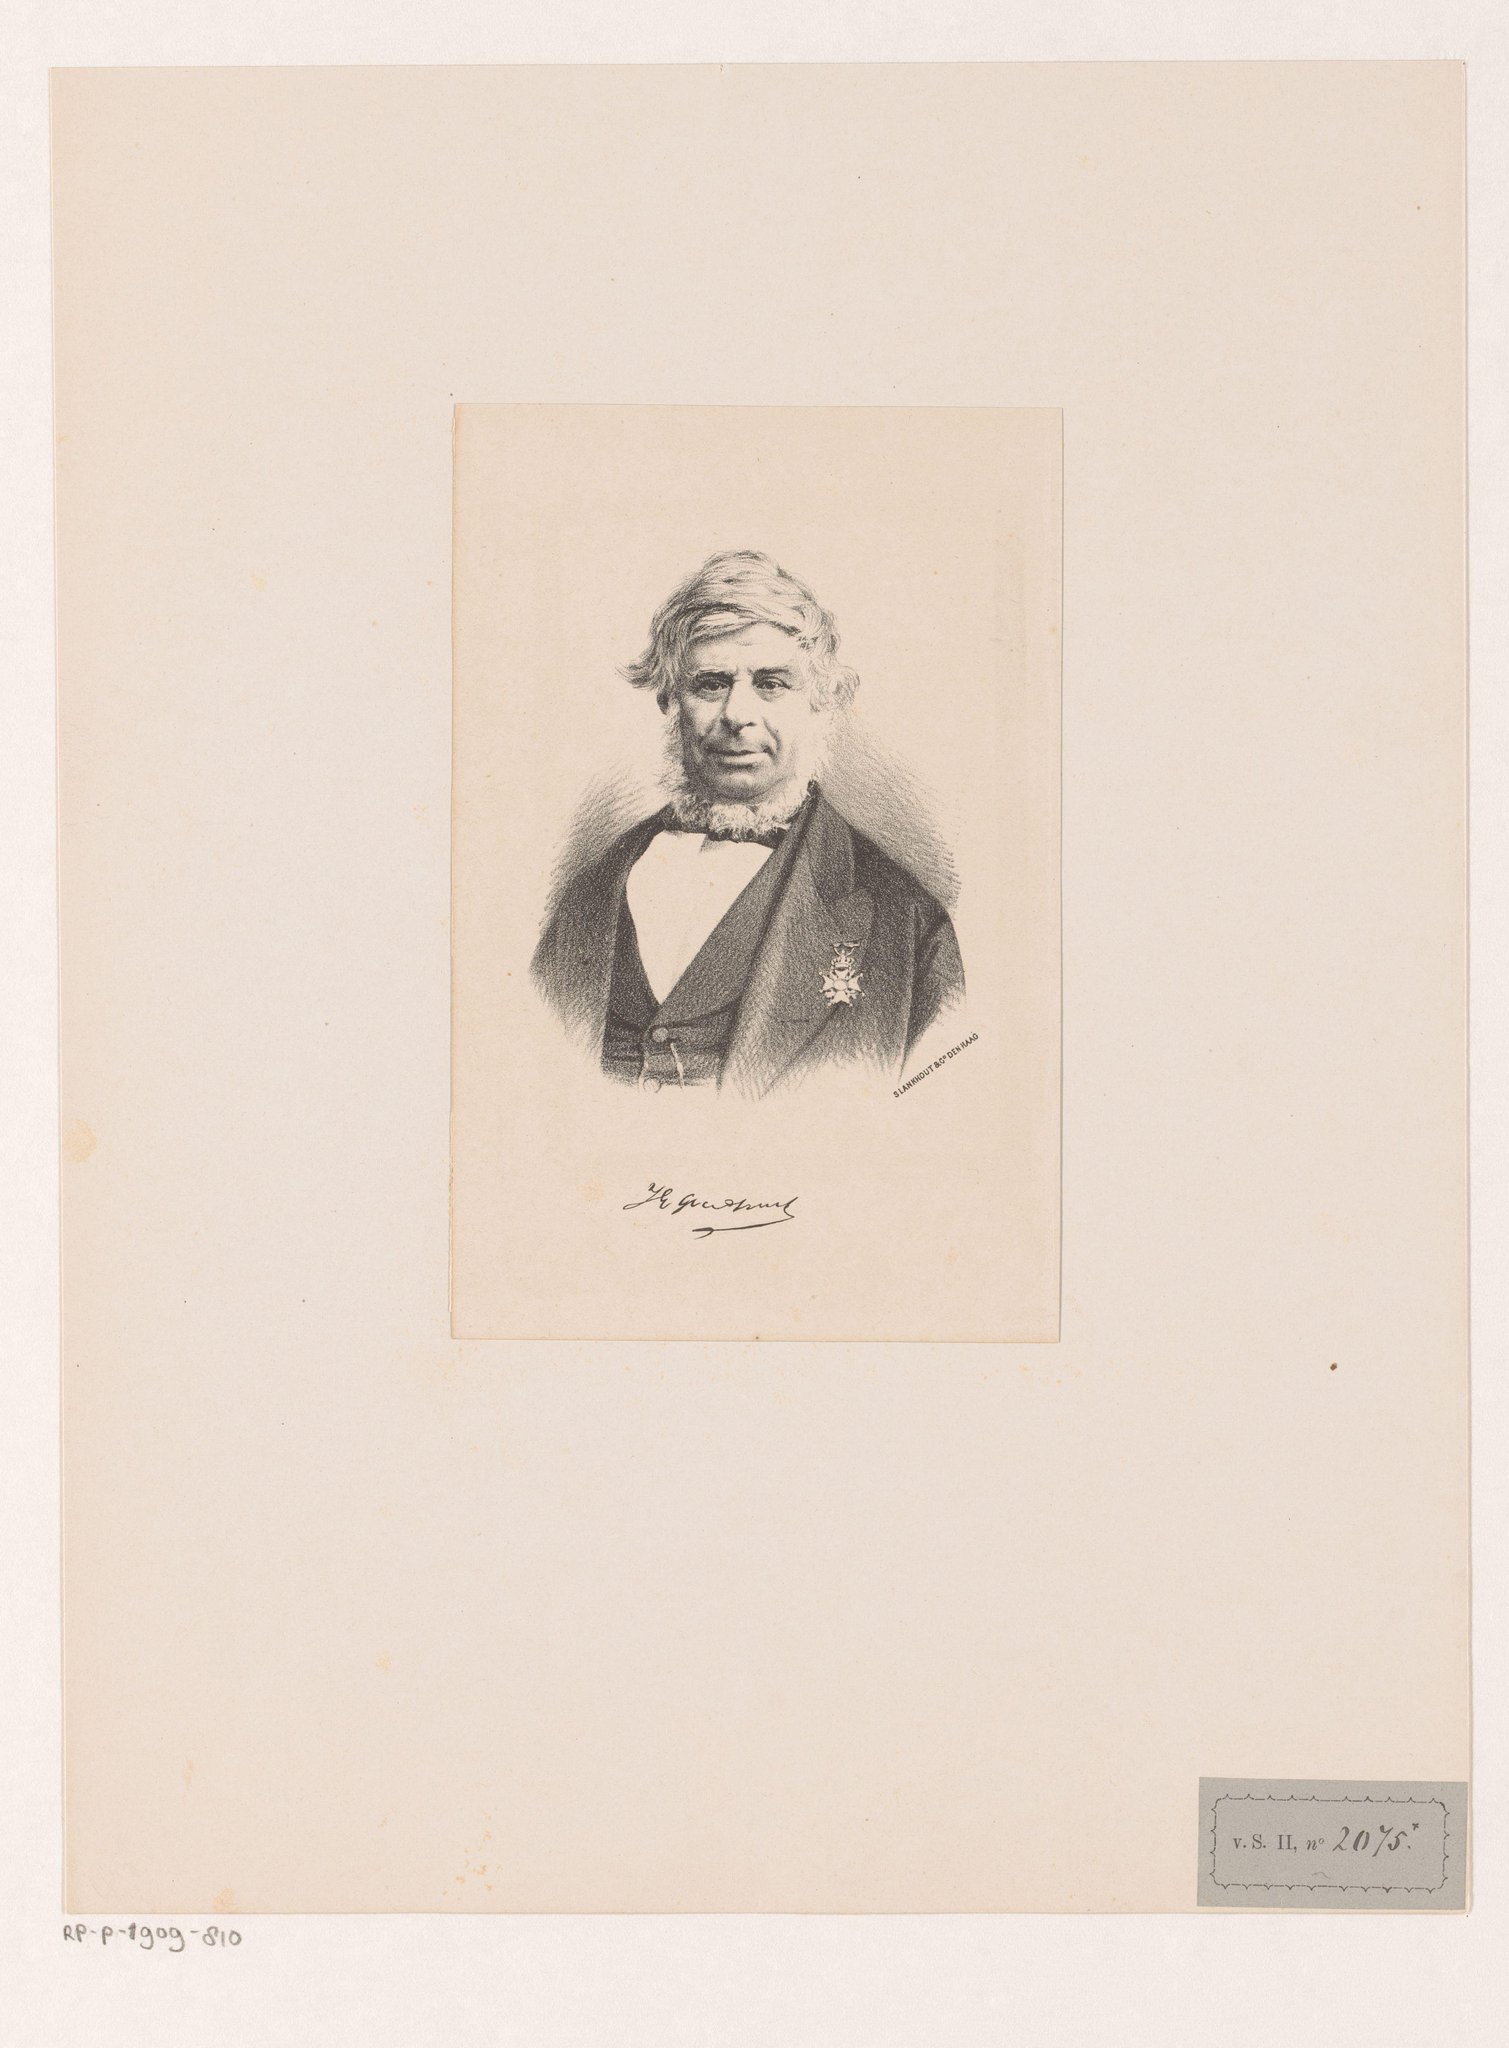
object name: print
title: Portret van Joël Emanuel Goudsmit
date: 1878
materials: paper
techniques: lithograph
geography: the hague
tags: leiden, knighthood order, historical persons (+ (full) bust portrait)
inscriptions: collector's mark: Lugt 2228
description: De geportretteerde draagt een ridderorde. Onder het portret zijn signatuur.